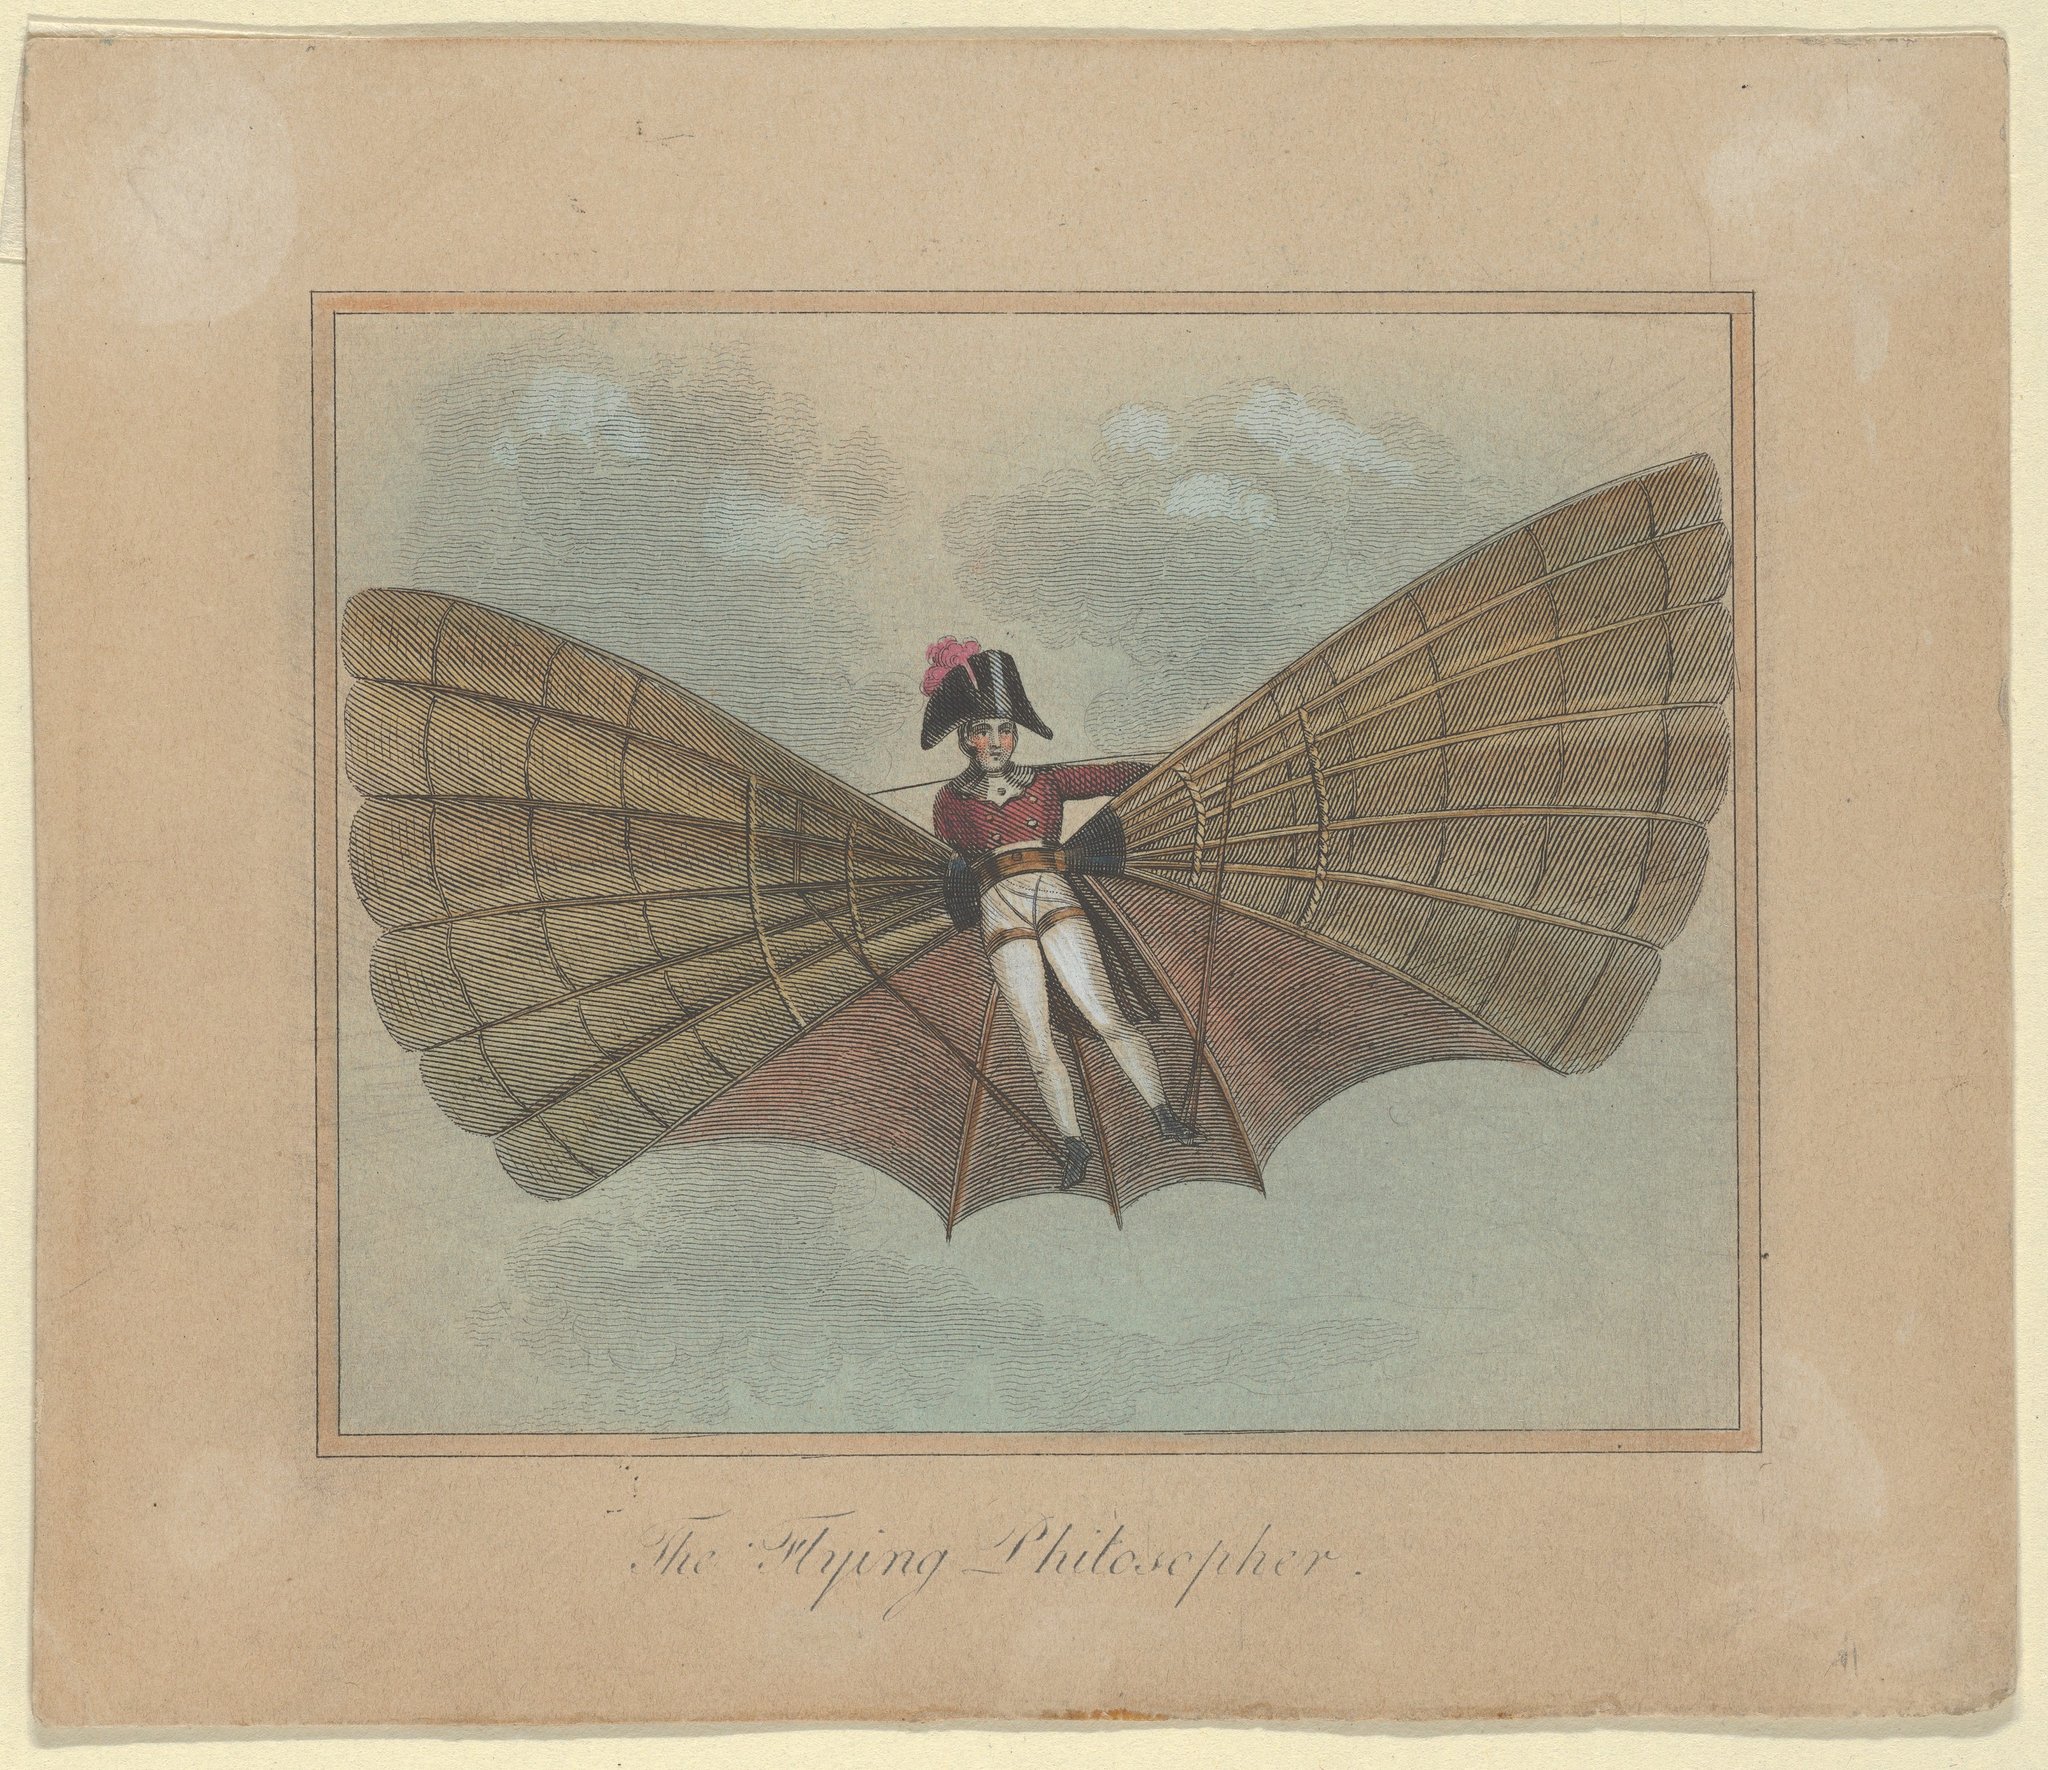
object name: print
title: The Flying Philosopher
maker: Anonymous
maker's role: artist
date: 1800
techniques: etching, hand coloring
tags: men